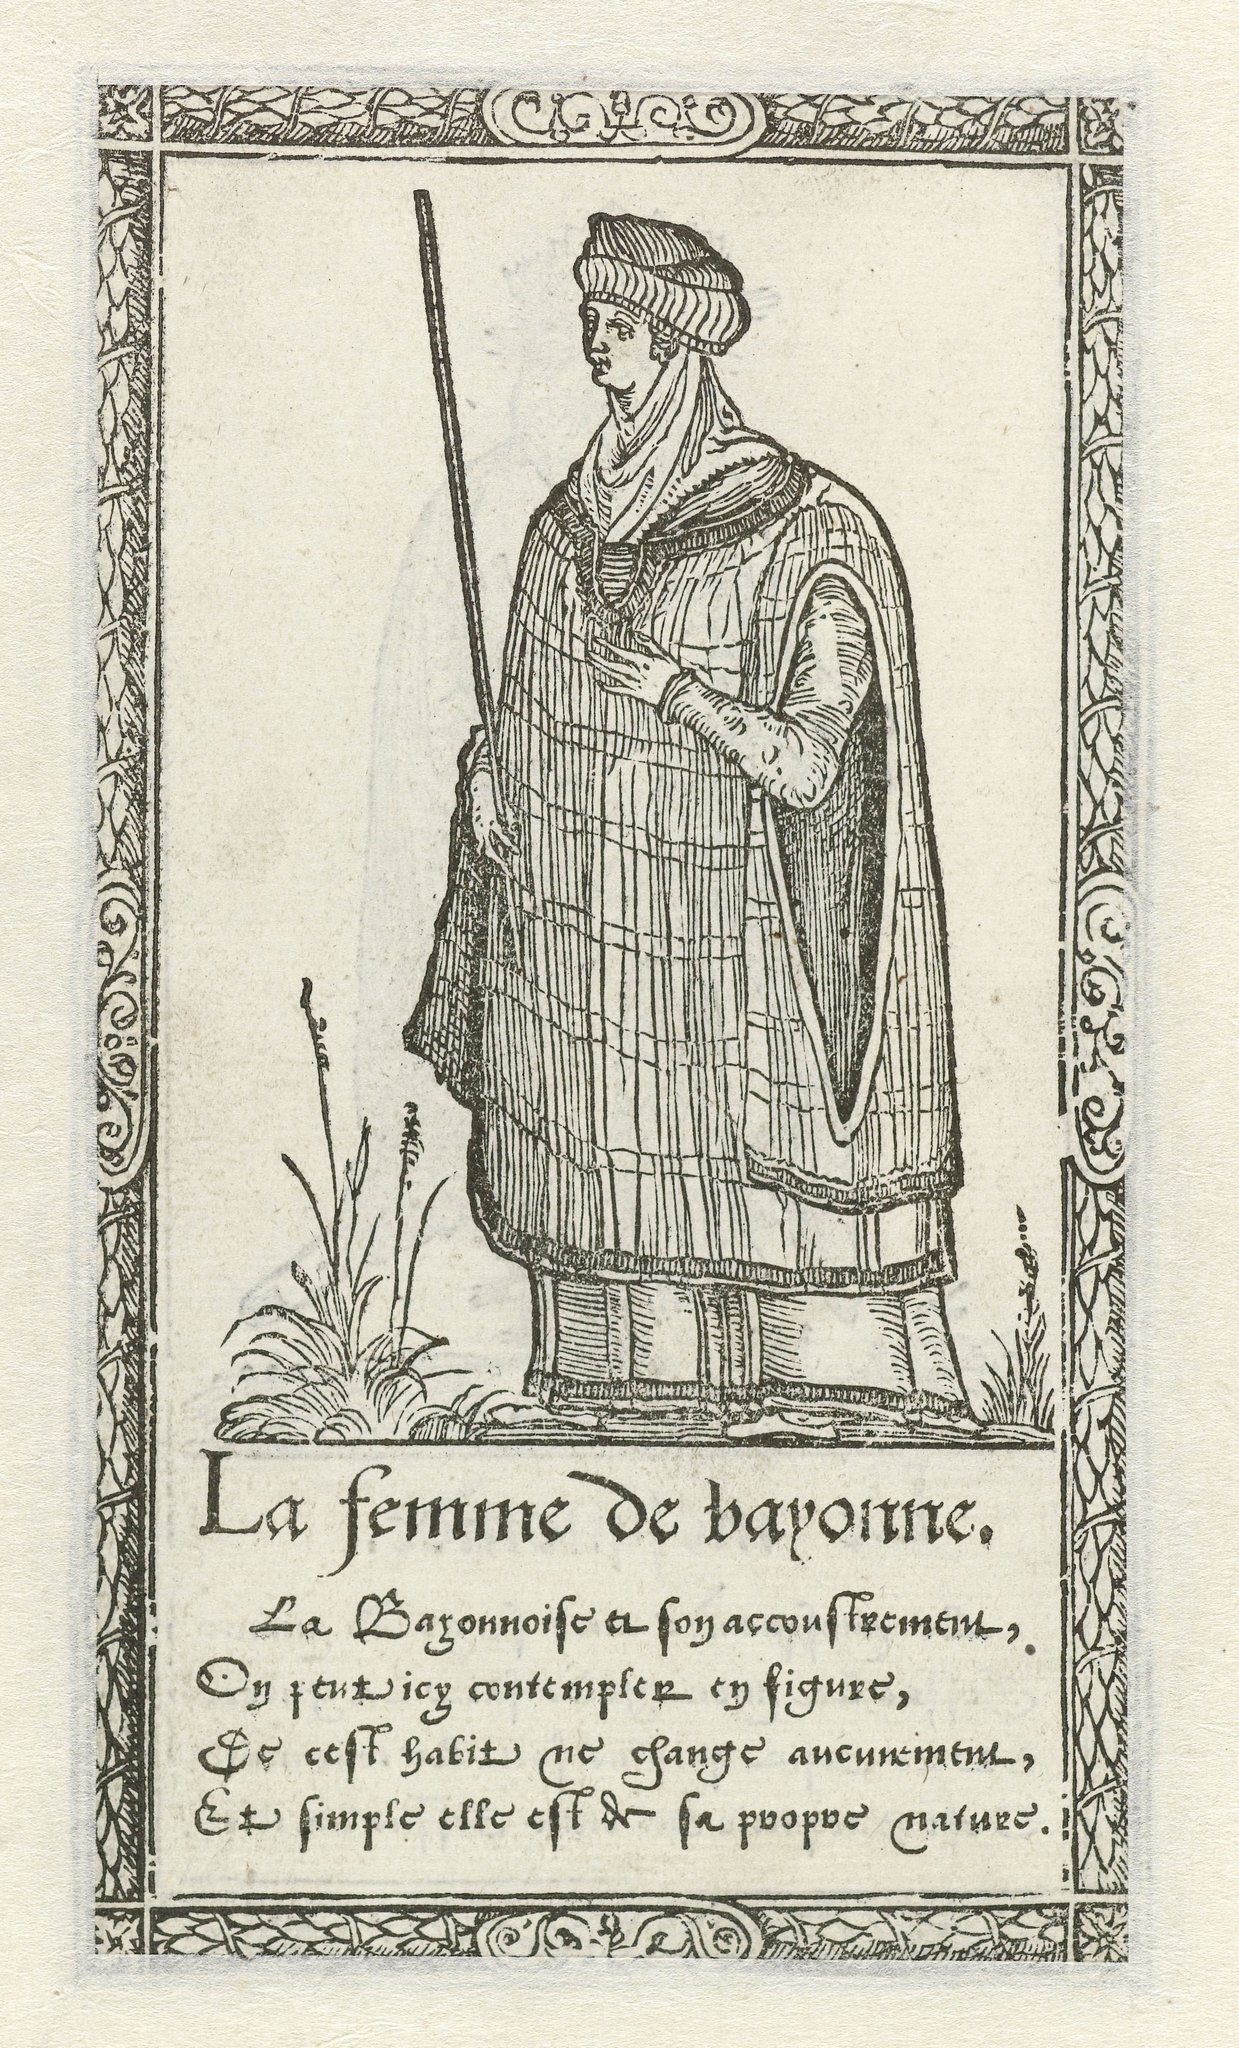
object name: print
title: Vrouw uit Bayonne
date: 1562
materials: paper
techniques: woodcut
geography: paris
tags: europeans (with name) (+ costume), fashion plates, head-gear: turban, folk costume, regional costume, coat, cape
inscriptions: collector's mark: Lugt 2228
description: Dit is prent 68 uit een serie van 121. Binnen deze serie zijn er prenten gemaakt naar voorbeelden van Jean-François de Roberval en Enea Vico, onbekend welke precies.